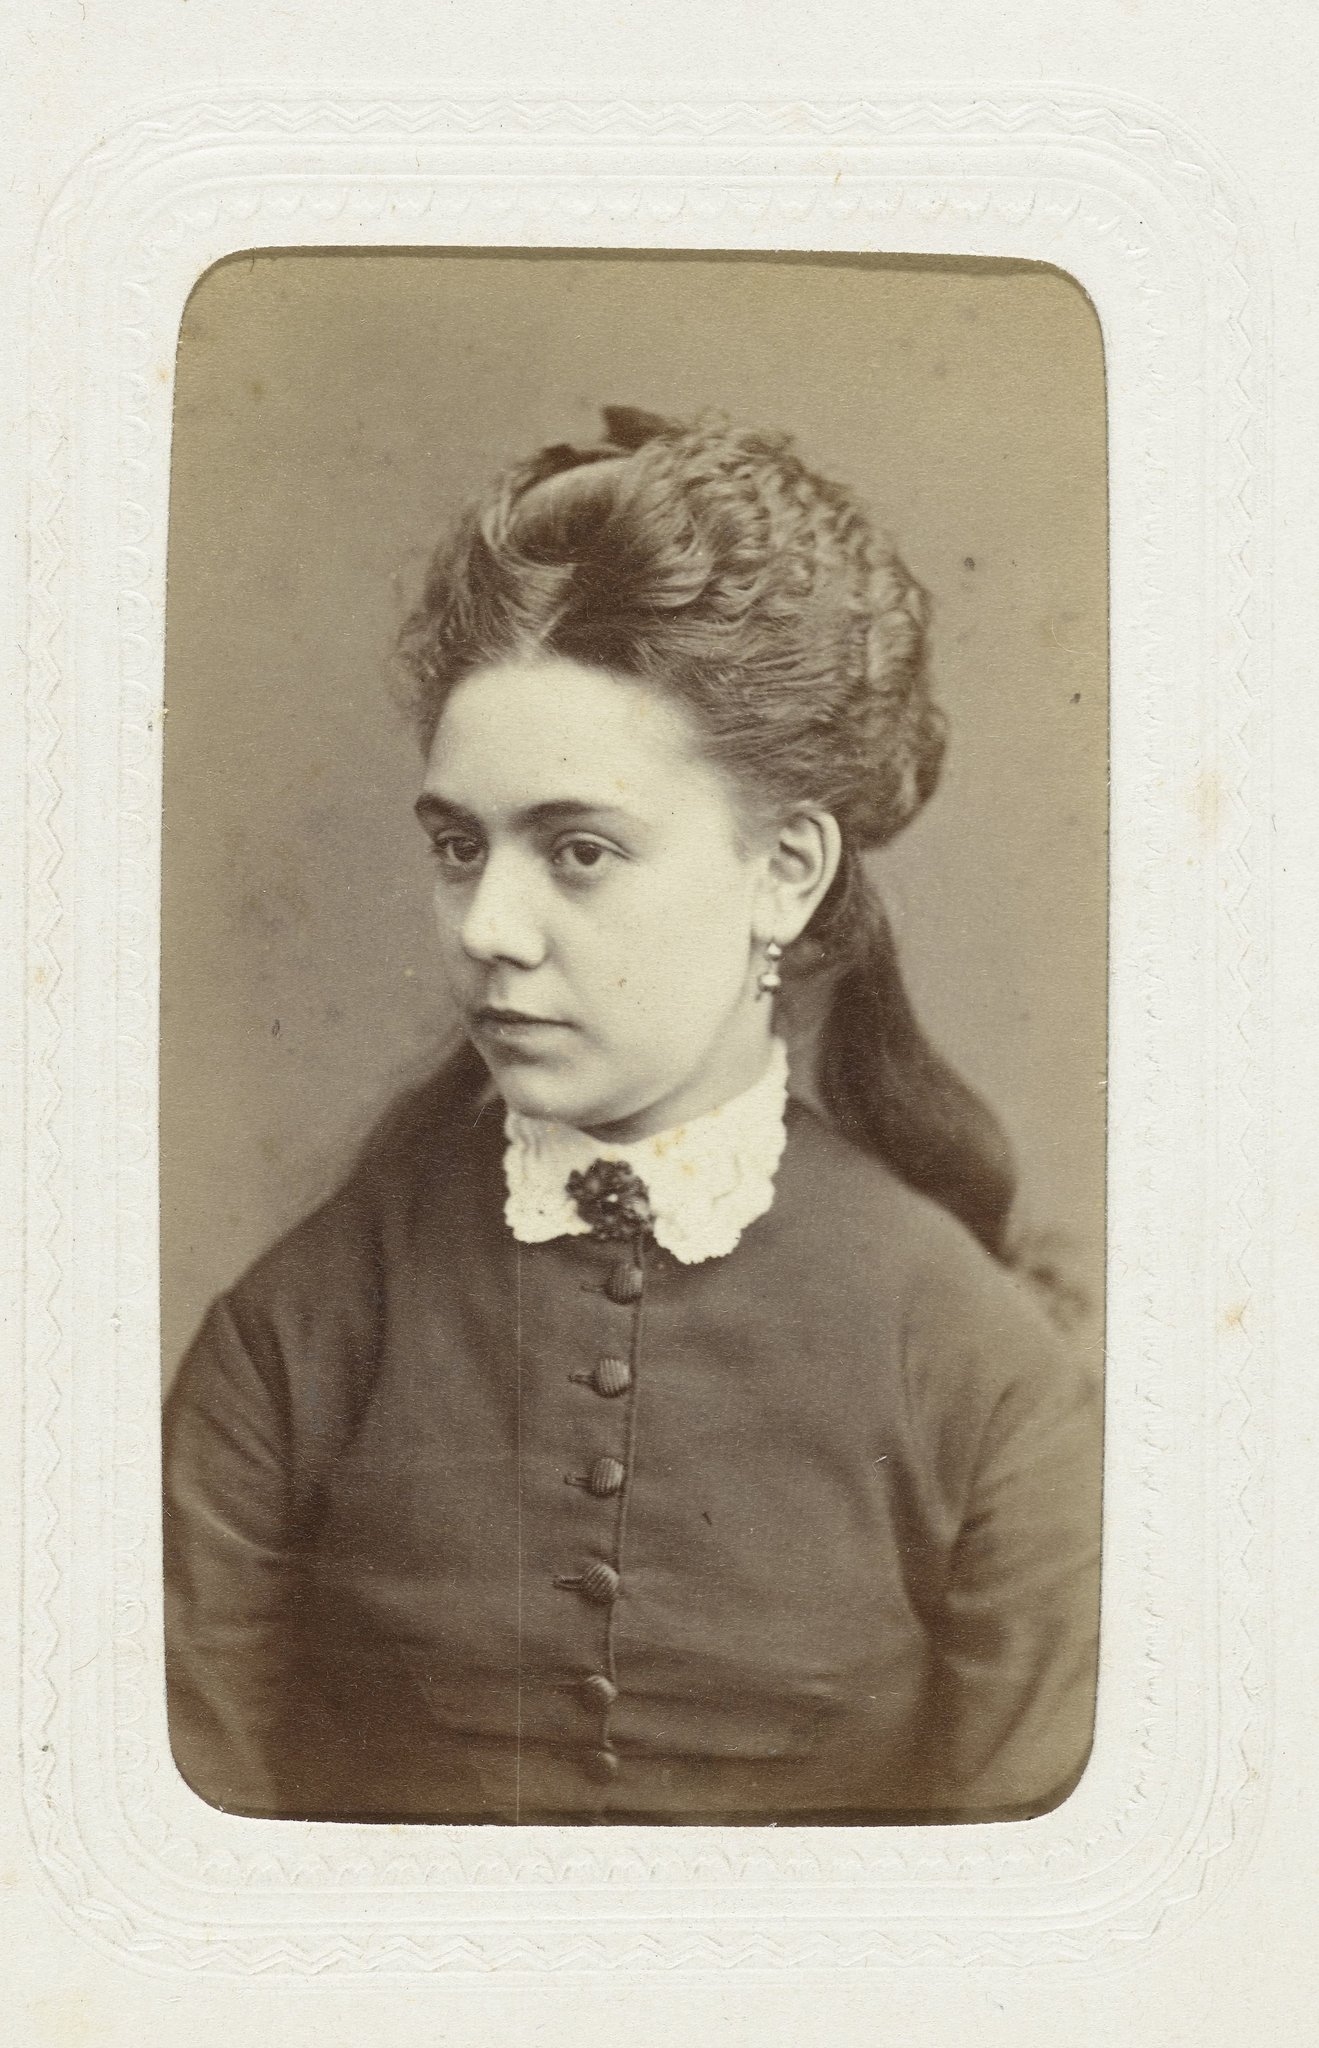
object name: carte de visite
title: Studioportret van een jonge vrouw met lang, donker haar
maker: albert greiner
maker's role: fotograaf, fotostudio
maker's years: 1833-1890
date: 1863-1866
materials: cardboard, paper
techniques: albumen print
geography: amsterdam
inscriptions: name: ‘A. Greiner, Amsterdam’